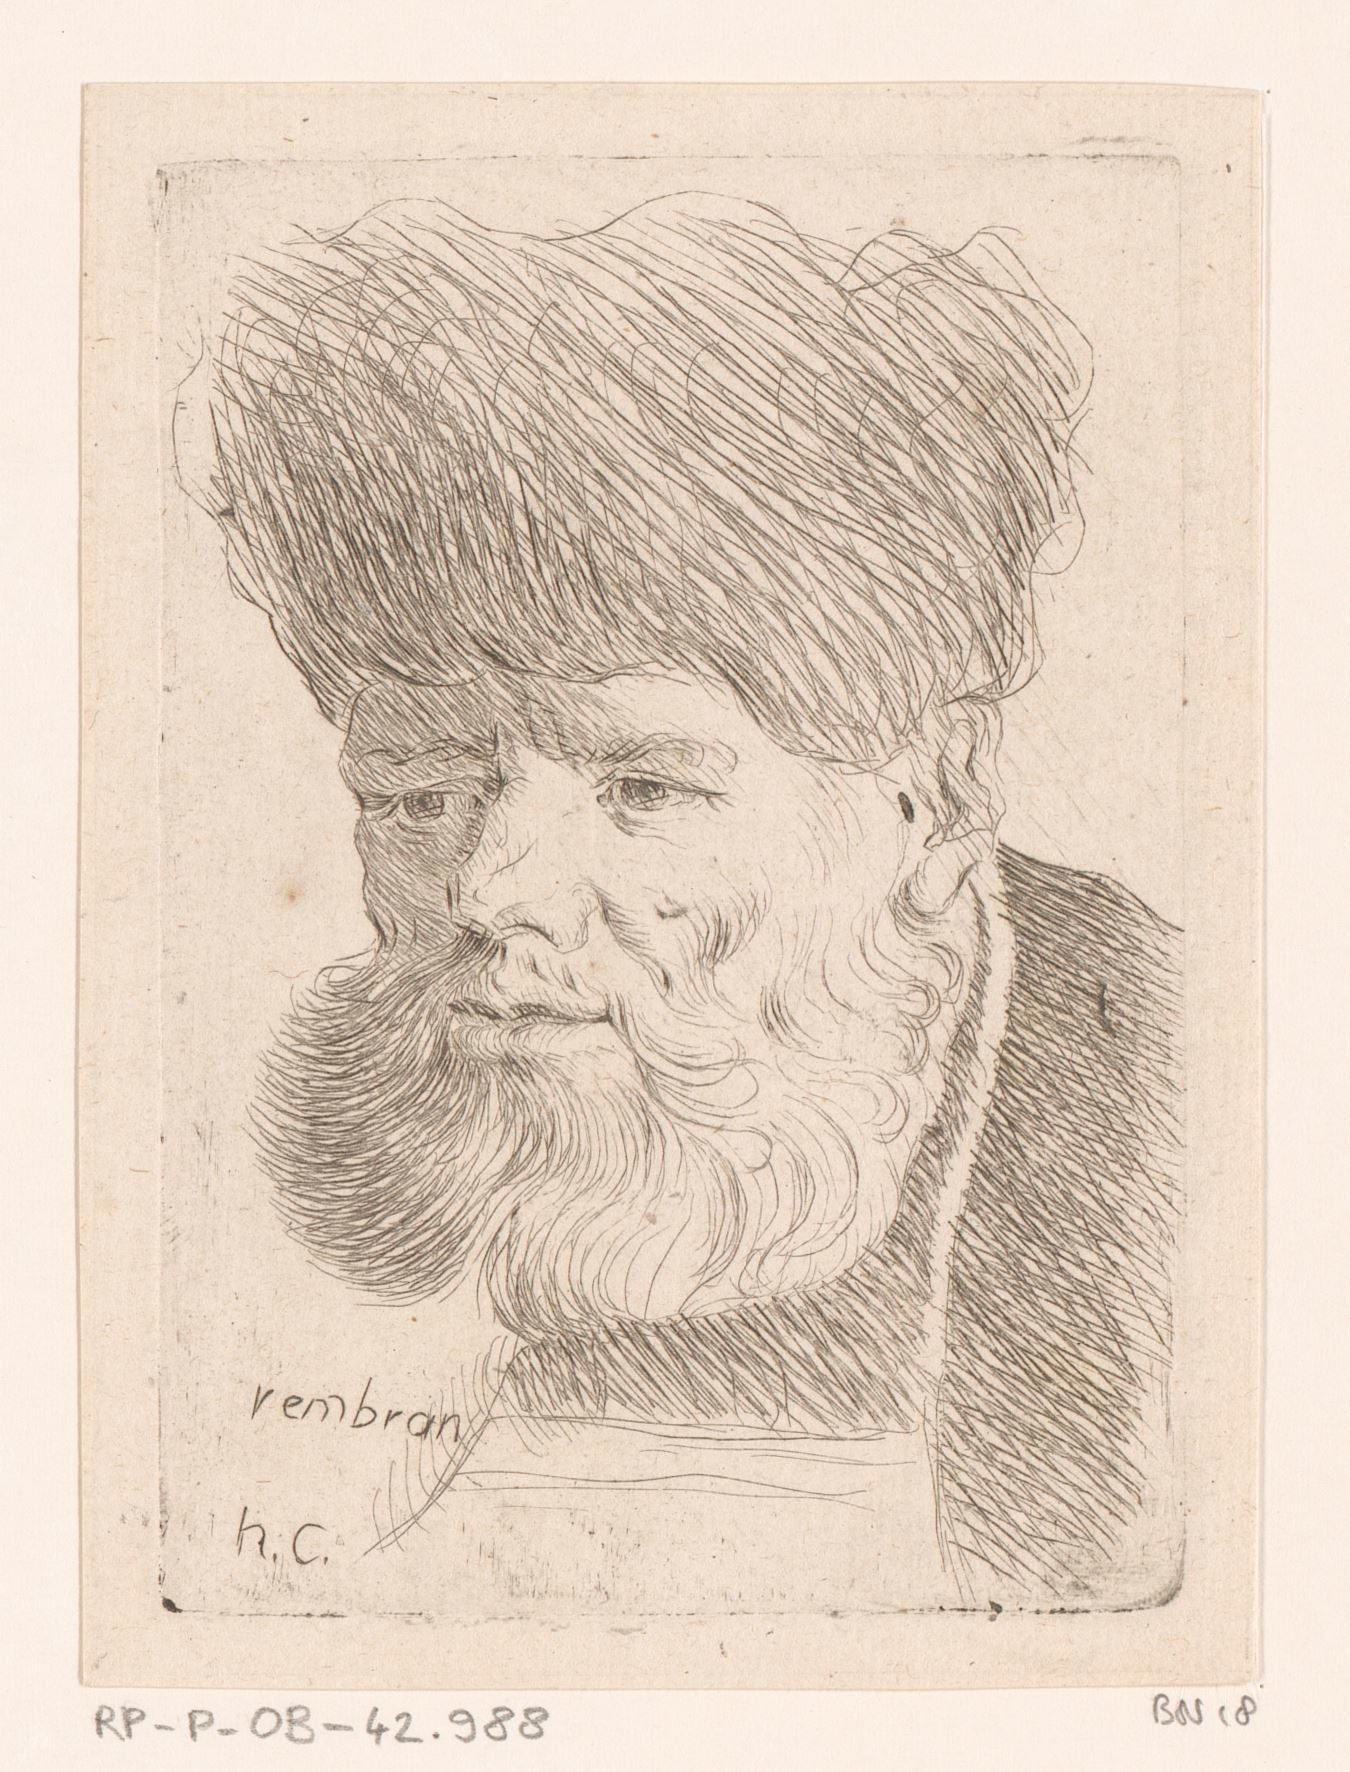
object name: print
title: Hoofd van een man met hoed en baard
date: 1708-1779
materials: paper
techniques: etching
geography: france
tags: beard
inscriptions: collector's mark: Lugt 240